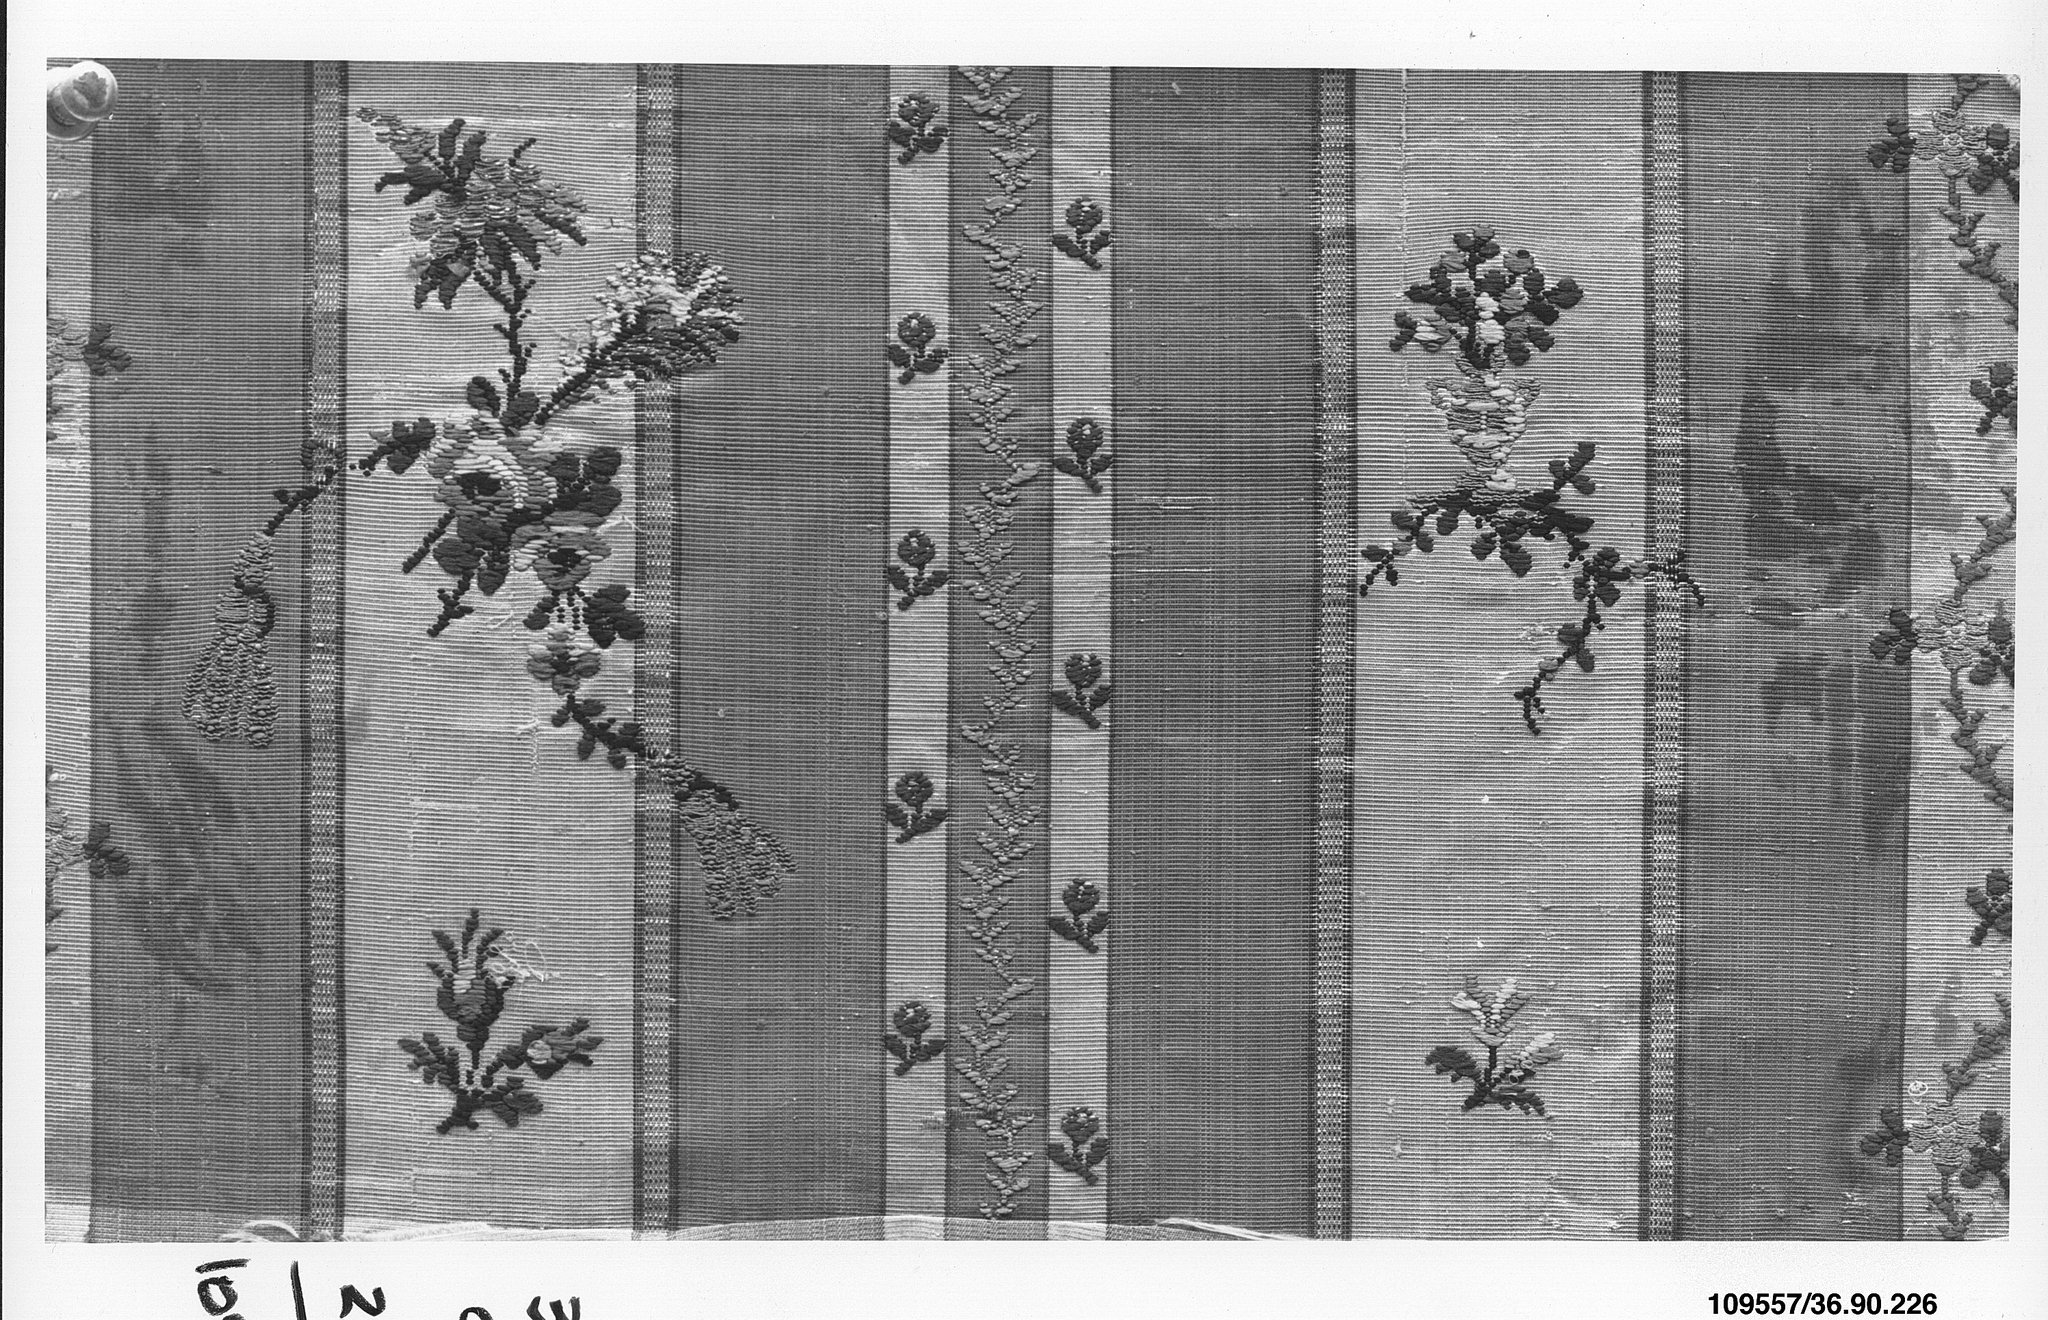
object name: piece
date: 1701-1800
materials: metal thread, silk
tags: flowers,leaves